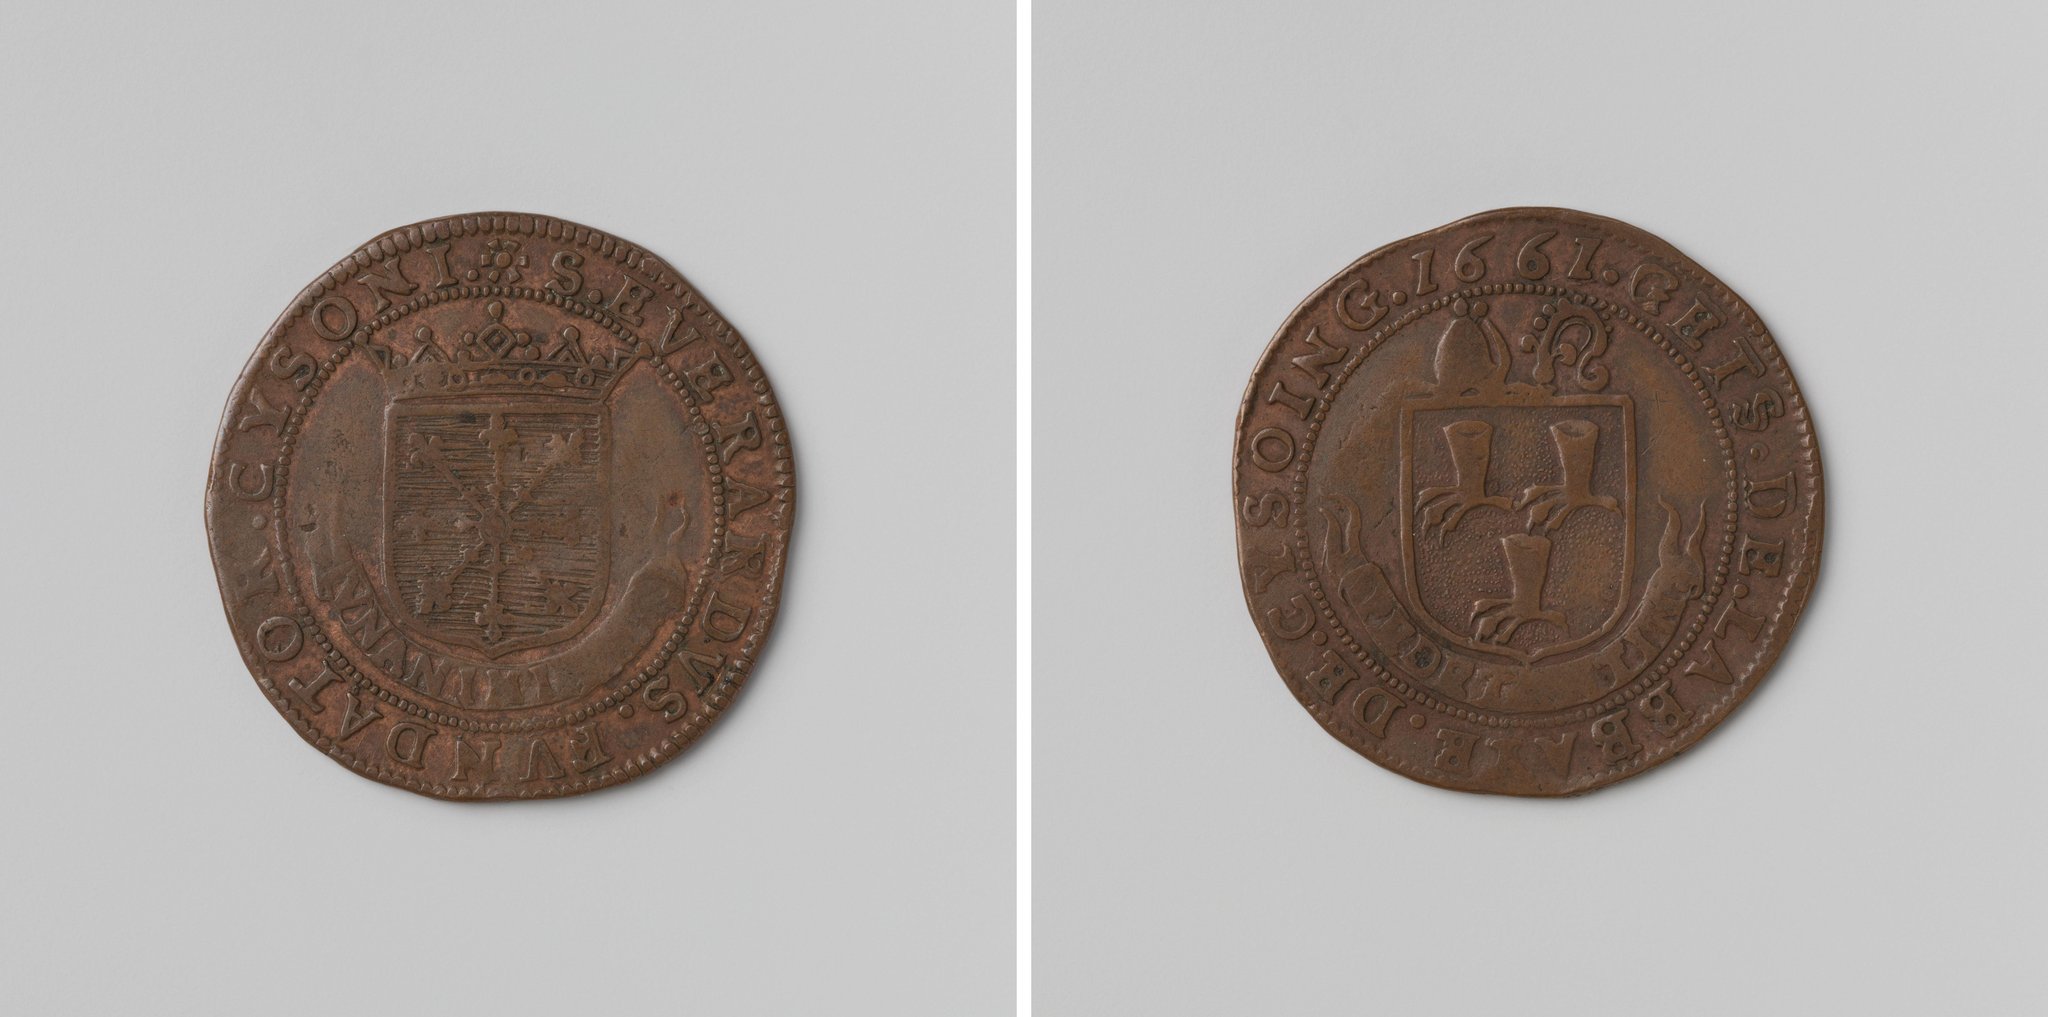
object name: jeton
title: Abdij van Cysoing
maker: Anonymous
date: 1661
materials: copper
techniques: striking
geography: belgium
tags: cysoing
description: Koperen penning. Voorzijde: gekroond wapenschild boven wimpel met opschrift binnen omschrift. Keerzijde: wapenschild, bekroond met mijter en bisschopsstaf boven wimpel met opschrift binnen omschrift